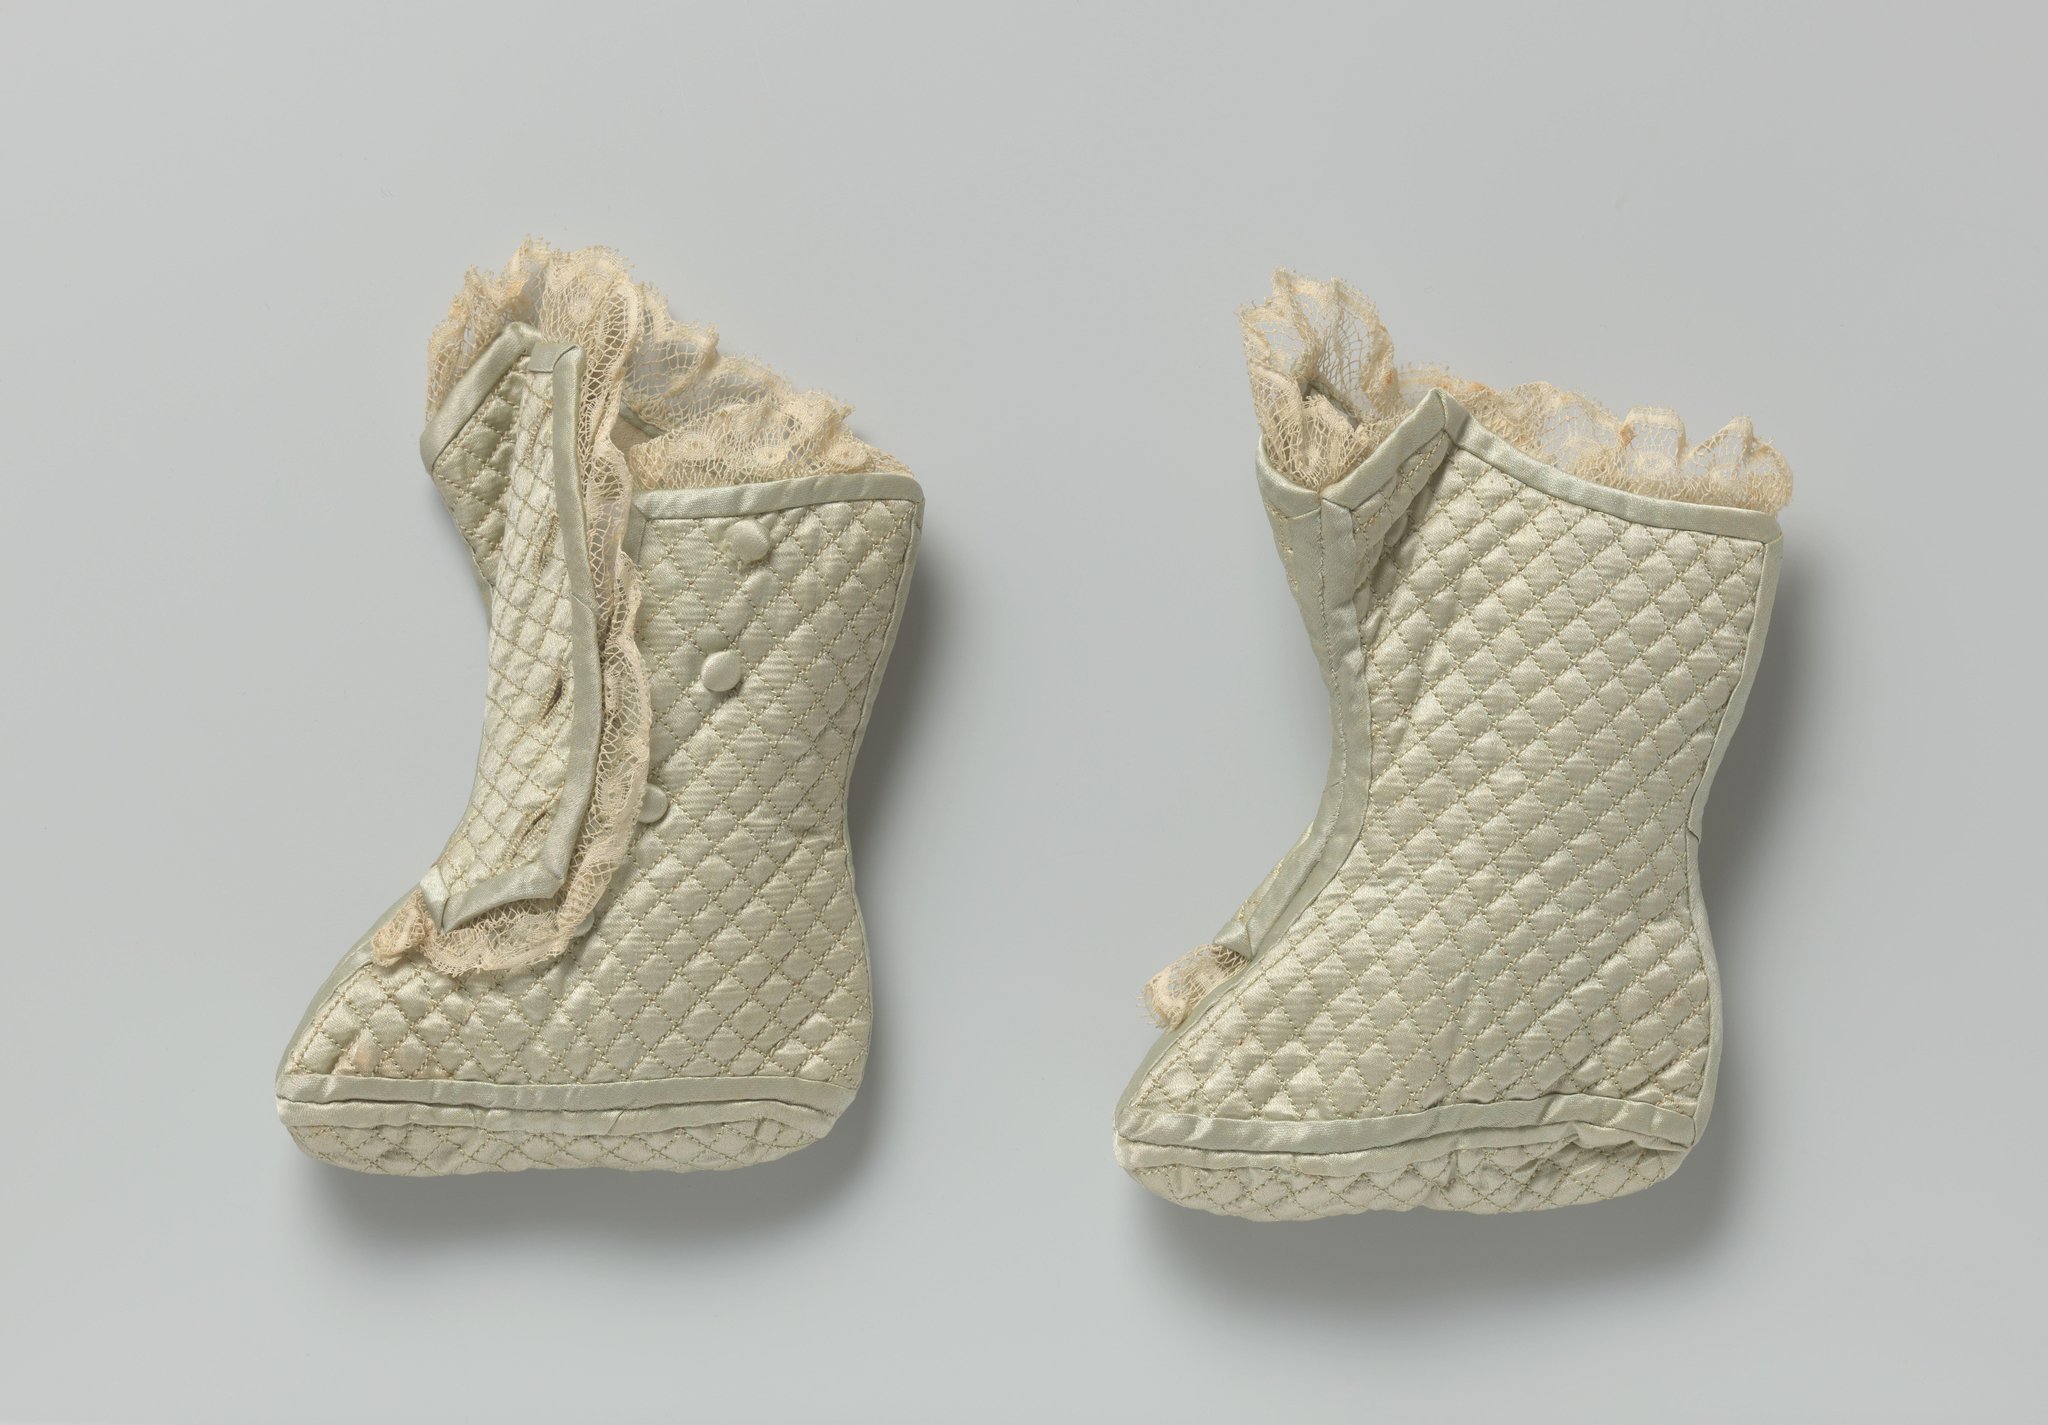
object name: babyschoentje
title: Babyslof (hoog model) van ruitvormig doorgestikte blauwe zijde, gevoerd met wol en afgezet met strook kloskant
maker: Anonymous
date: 1910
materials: linen, textile, silk, wood, wool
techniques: lace, turning, weave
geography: amsterdam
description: Babyslof (hoog model) van ruitvormig doorgestikte blauwe zijde, gevoerd met wol en afgezet met strookje kloskant. Model: schacht bestaande uit twee delen met extra flap als overslag, zijden zool. Schacht volgt vorm van been met ruimte voor de kuit. Flap eindigt middenvoor in een opstaande punt. Gevoerd met lichtblauwe wol. Sluiting door middel van vier satijnen knoopjes. Versiering: langs de naden afgezet met een strookje lichtblauwe satijn. Hetzelfde is gebruikt voor de knoopjes. Bovenaan de schacht en langs de flap voorzien van een gerimpeld strookje kloskant.